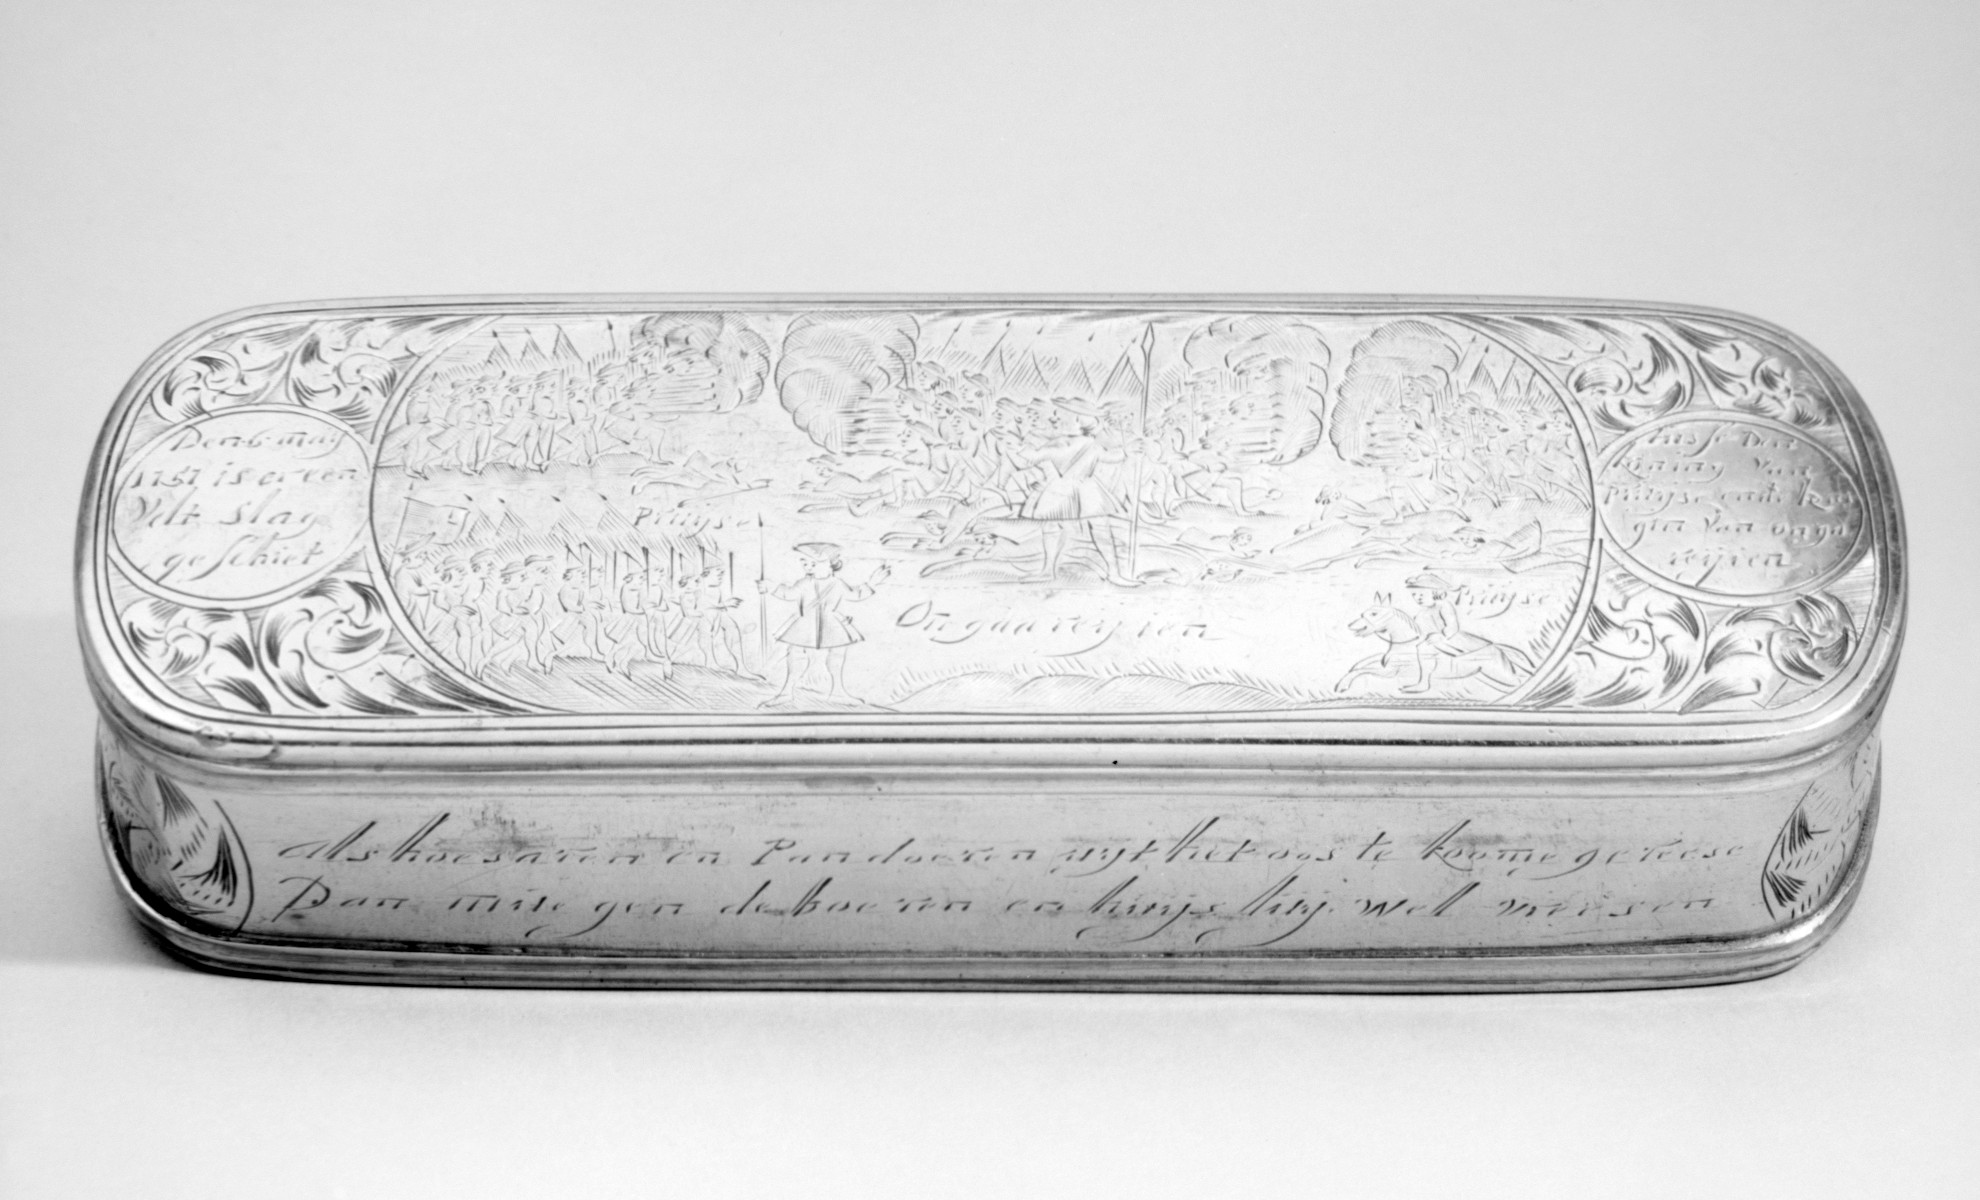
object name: tobacco box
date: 1751-1800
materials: brass, copper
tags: buildings,soldiers,horses